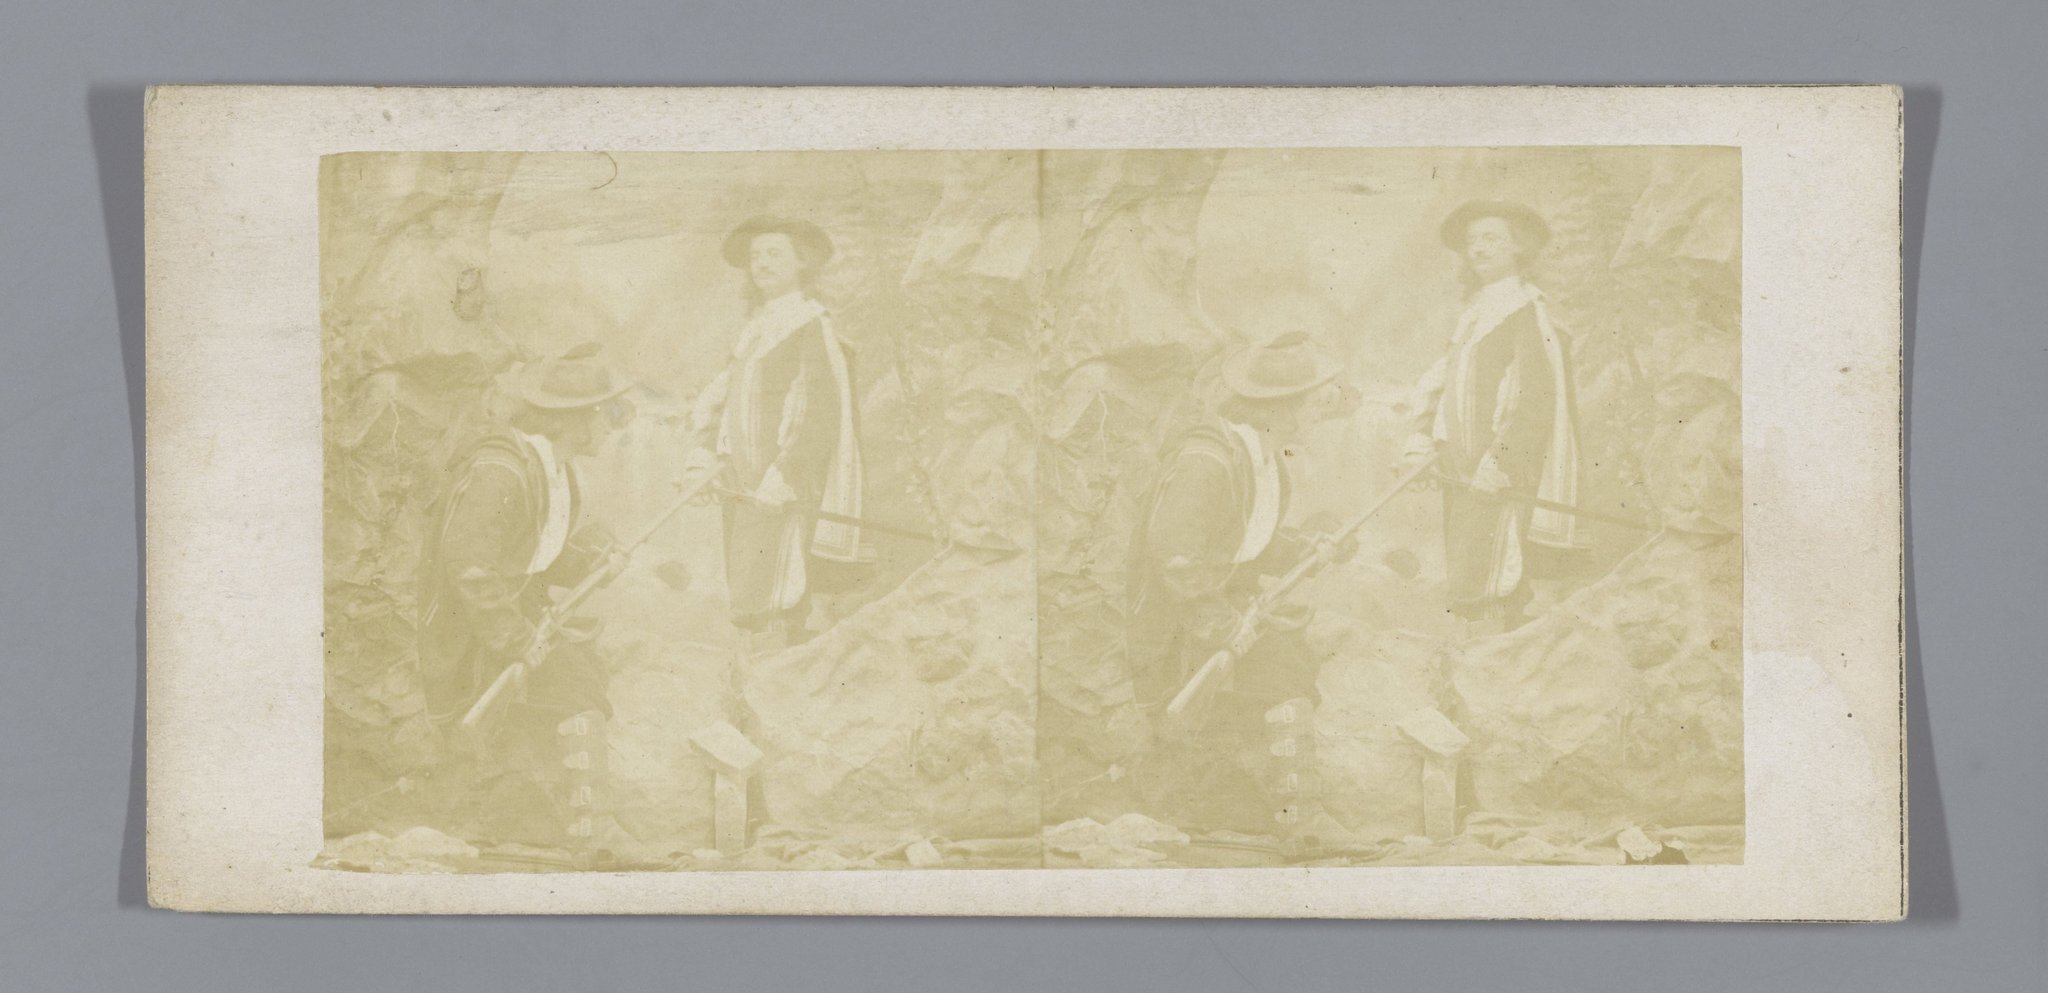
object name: stereograph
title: Twee mannen in historische kostuums met wapens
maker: Anonymous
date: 1850-1880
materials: cardboard, photographic support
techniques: albumen print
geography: europe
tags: weapons, historical costume, europe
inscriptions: number: ‘No. 33.’